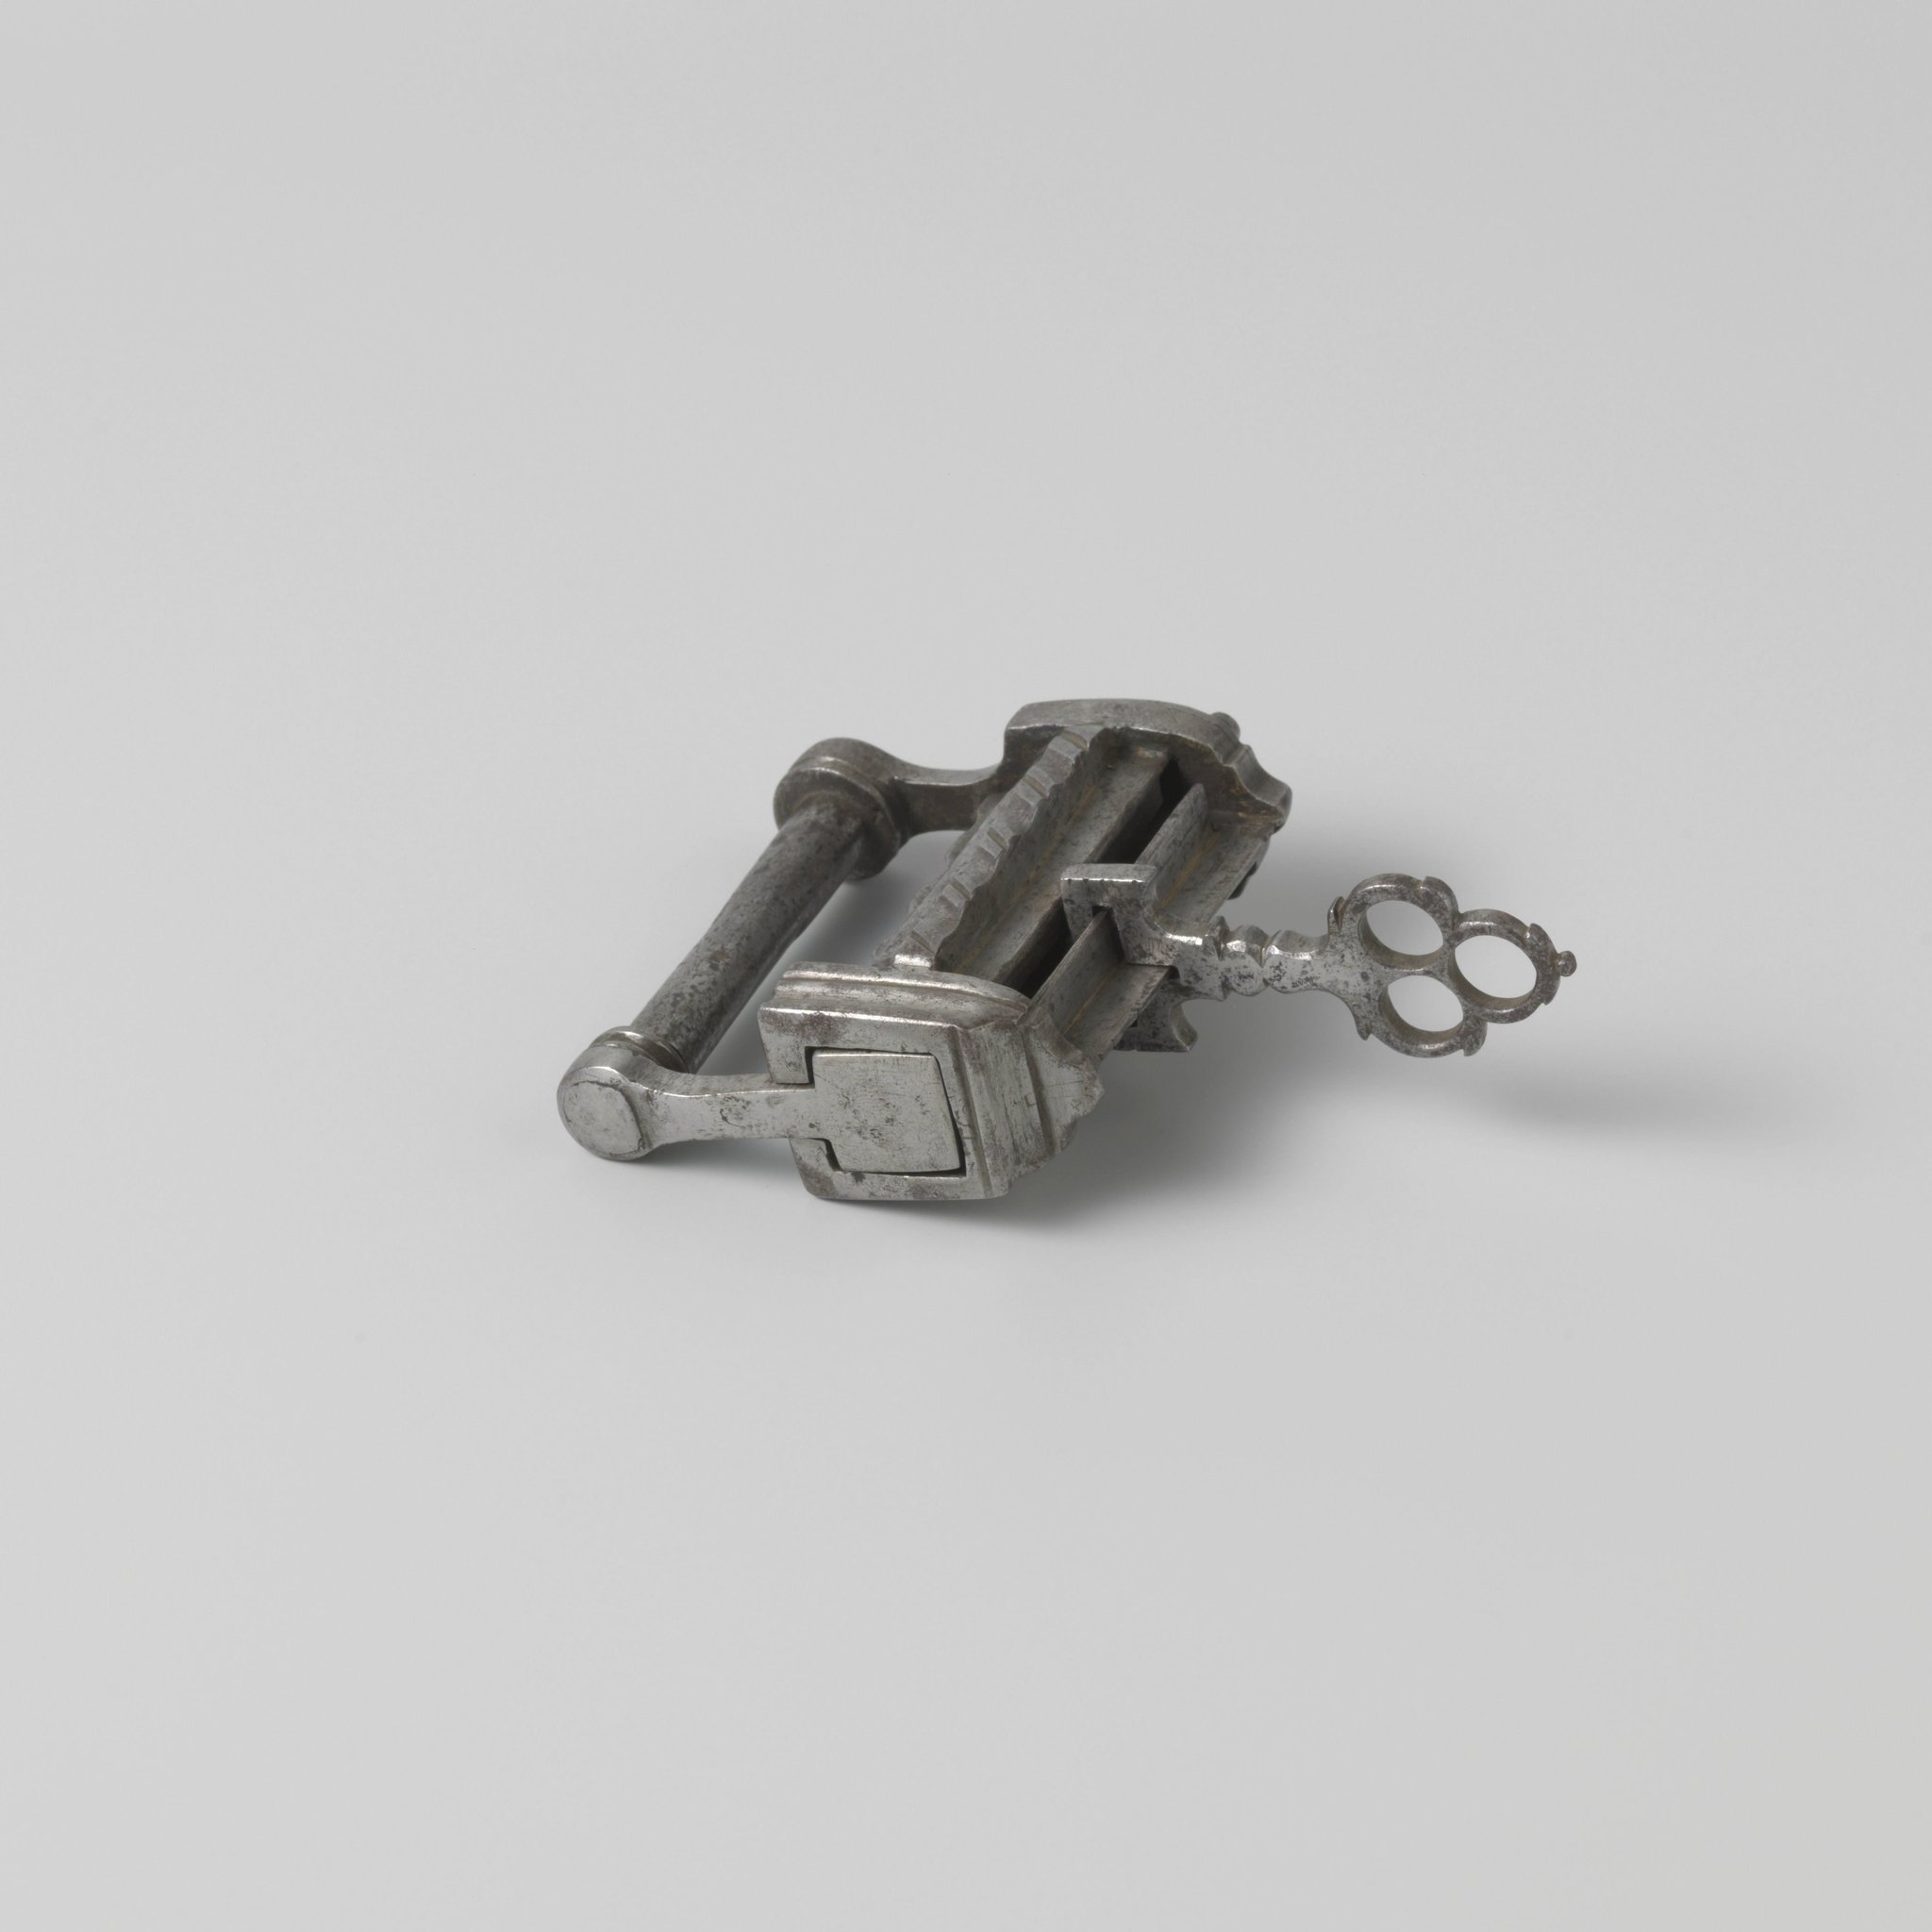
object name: padlock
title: Een langwerpige hangslot met sleutel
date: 1400-1950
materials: iron